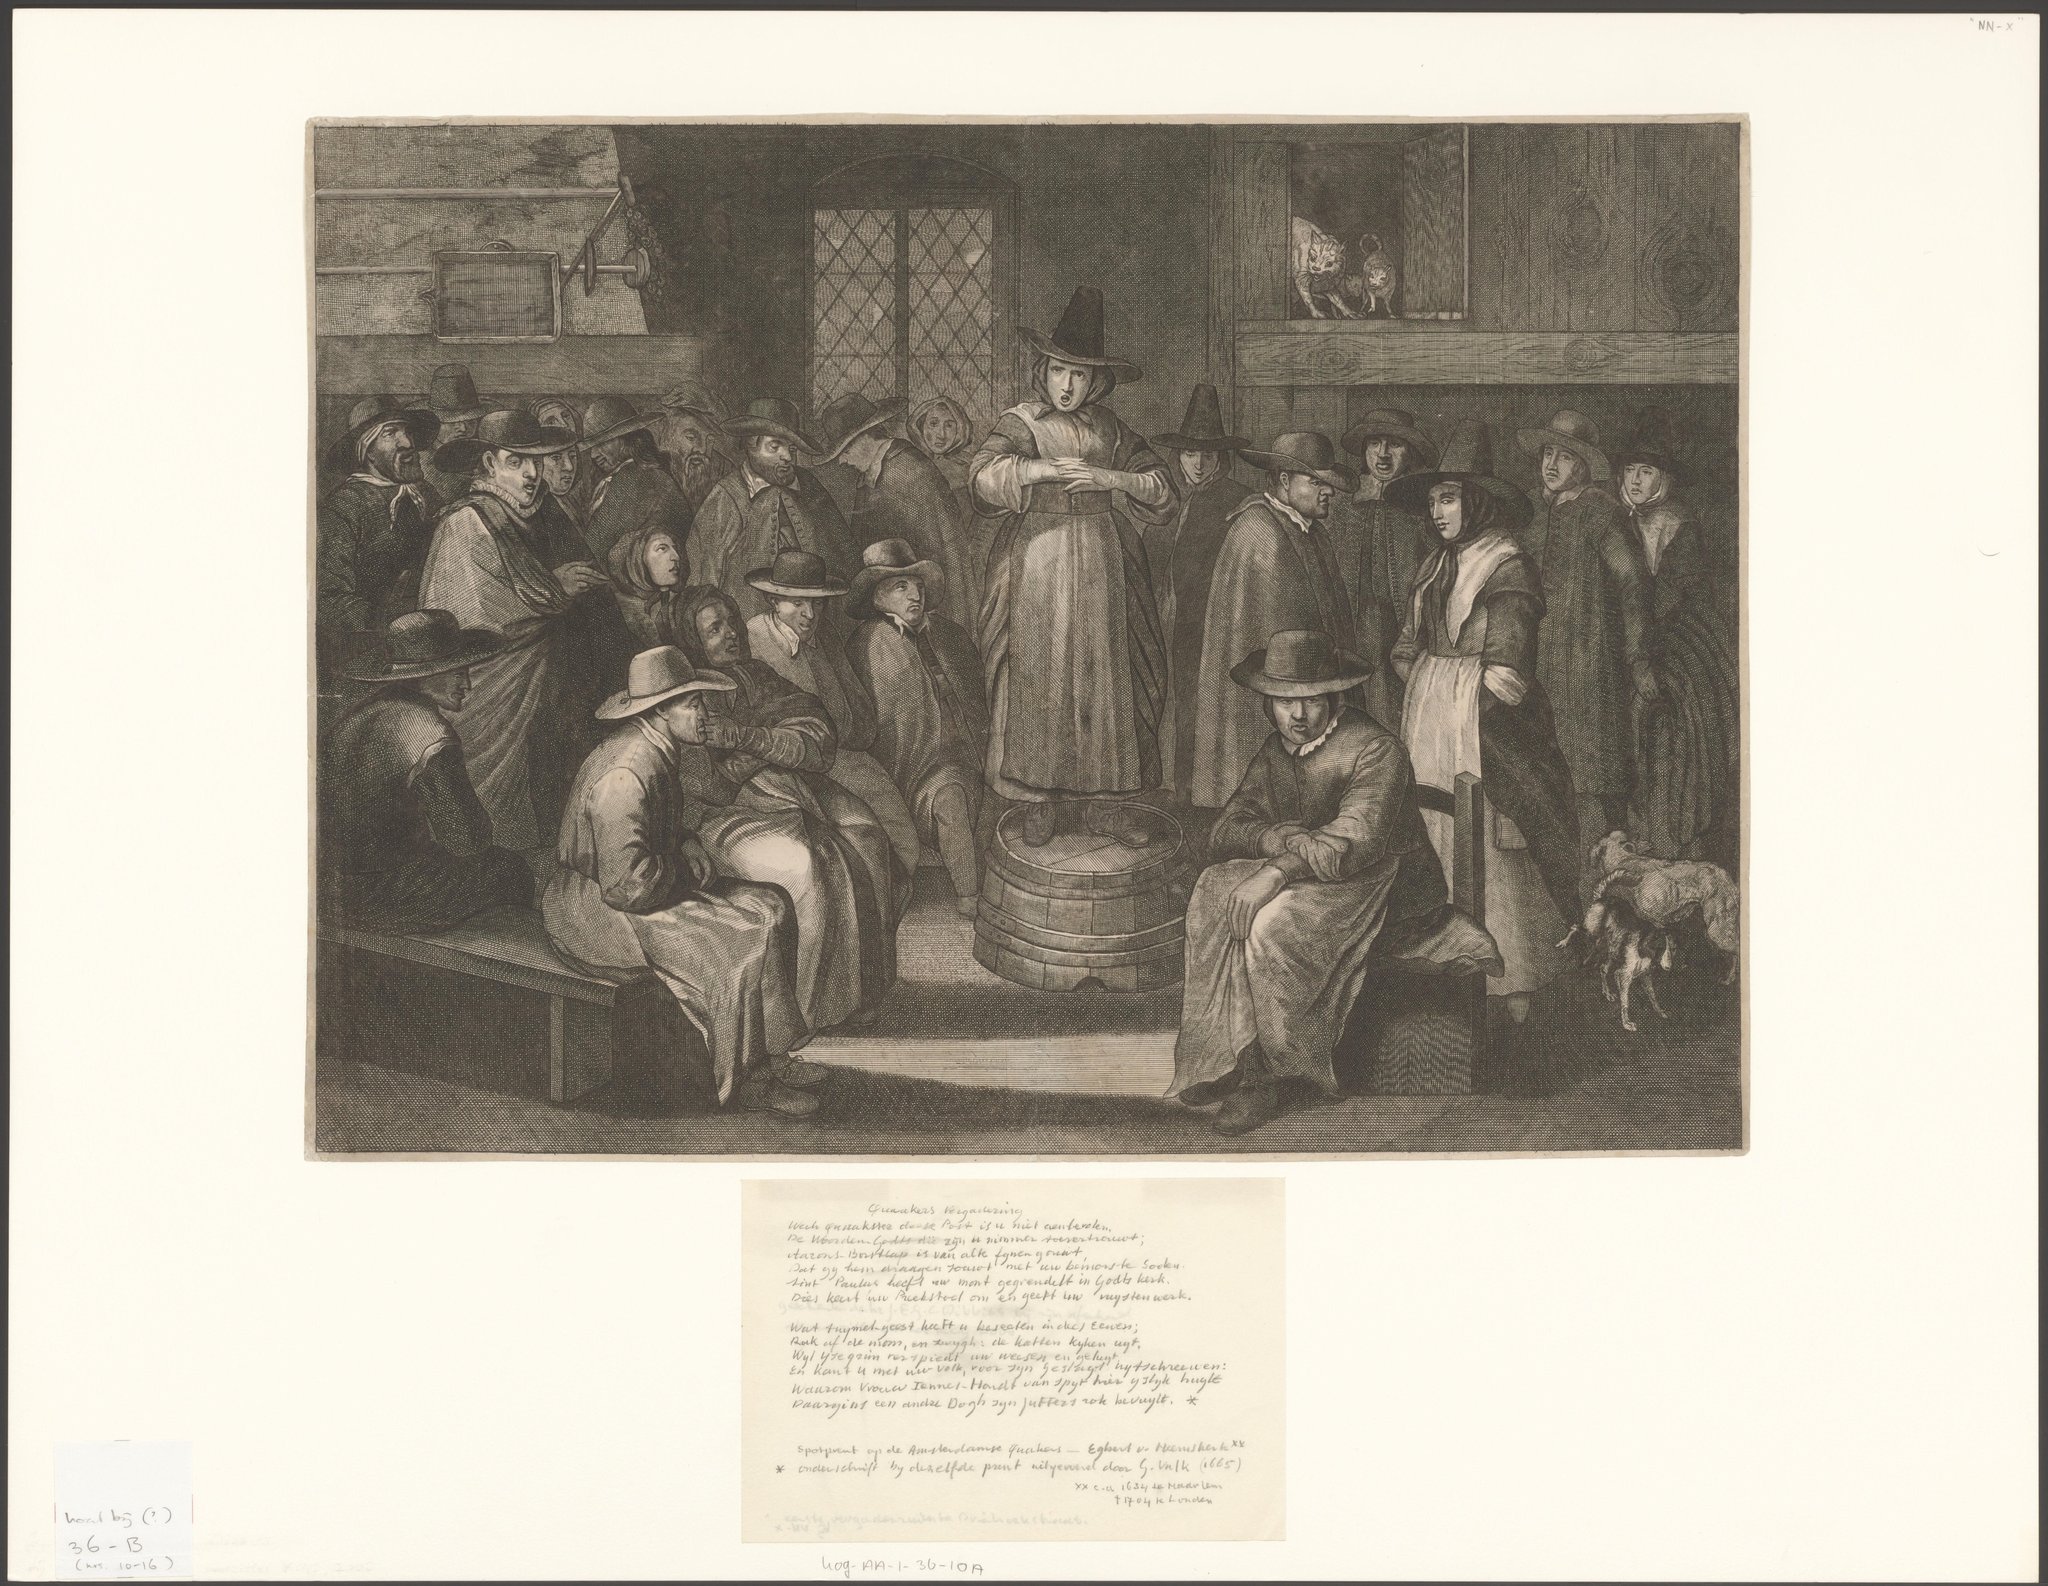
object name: print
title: Quaakersvergadering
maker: carel allard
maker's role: print maker, publisher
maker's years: 1648-1709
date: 1675-1699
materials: paper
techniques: engraving, etching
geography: amsterdam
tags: protestant churches and denominations (with name), england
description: Spotprent op Engelse Quakers, ca. 1656. Bijeenkomst van Engelse mannen en vrouwen in het kostuum van de Quakers in een schuur, zij luisteren naar de preek van een vrouw die op een omgekeerde ton staat. Boven in een kastje miauwen katten, rechts plast een hond tegen de rok van een vrouw. Op niet afgesneden afdrukken staat een vers waarin de Quakers belachelijk worden gemaakt in het Nederlands en Engels onder de voorstelling. Onderwerpsrubriek binnen de Atlas Amsterdam: Kerkwezen: Vrienden-Gemeente (Kwakers).